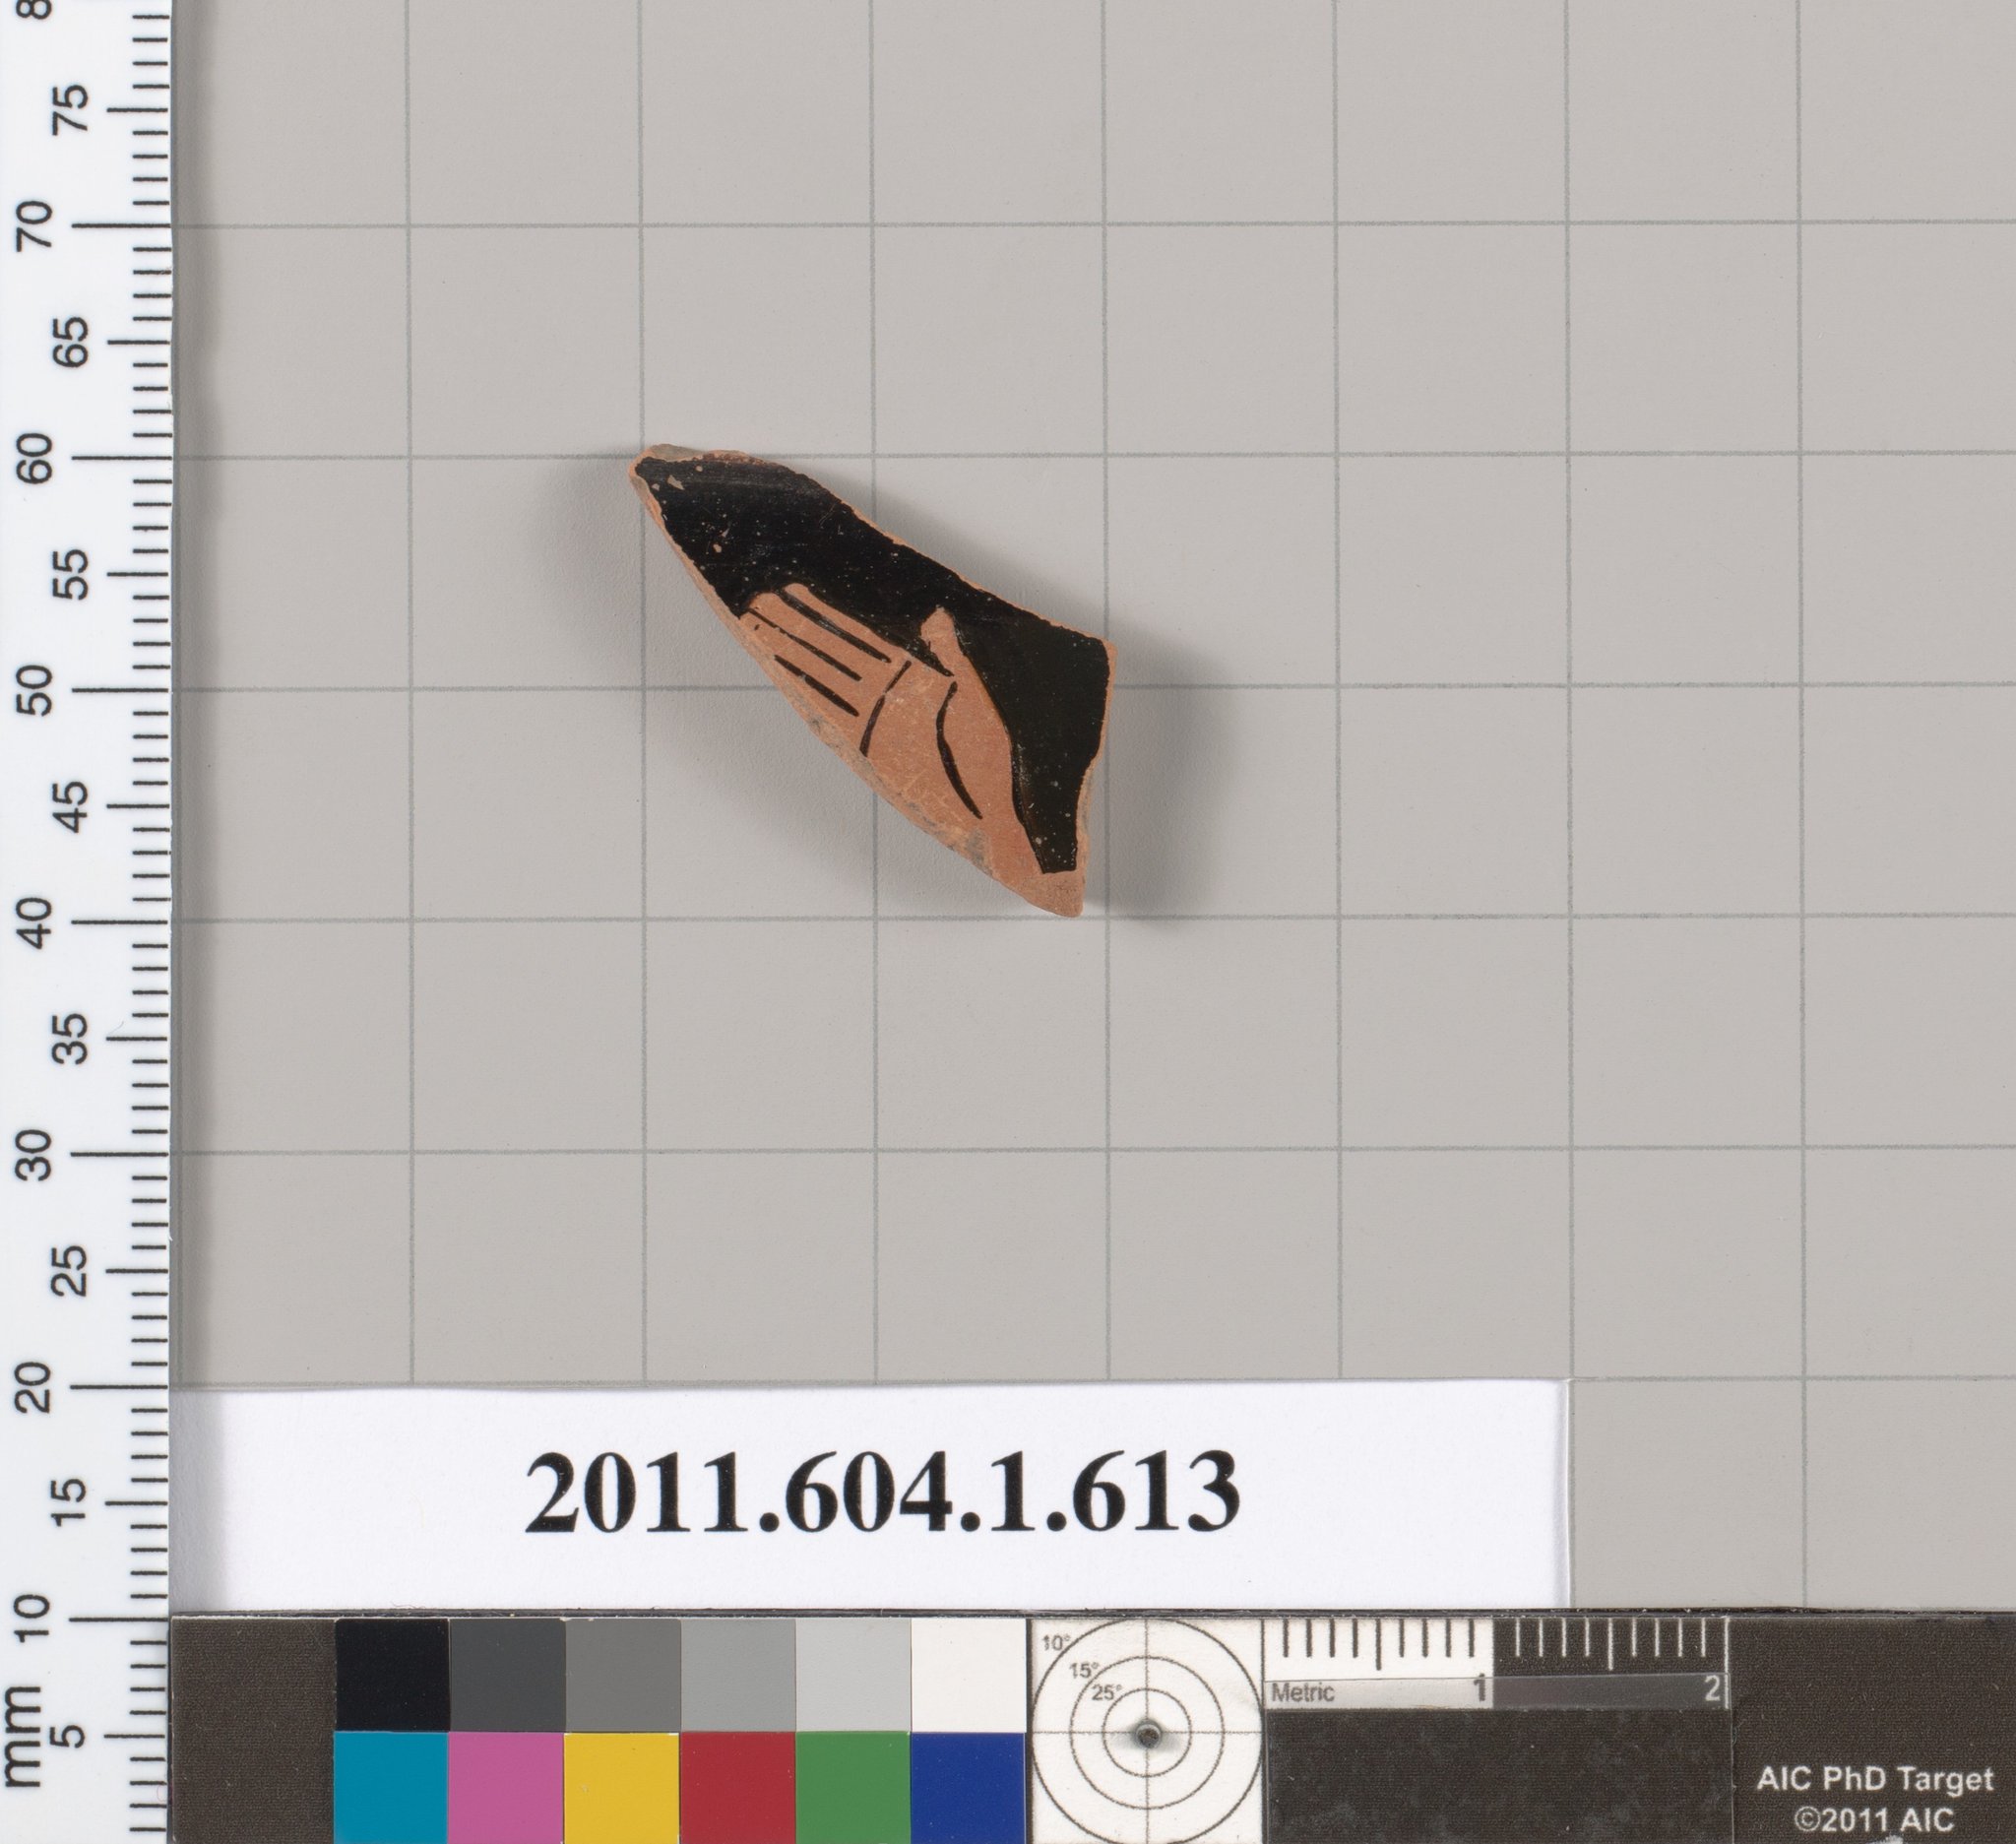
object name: kylix fragment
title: Terracotta fragment of a kylix (drinking cup)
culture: greek, attic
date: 475-451 BCE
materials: terracotta